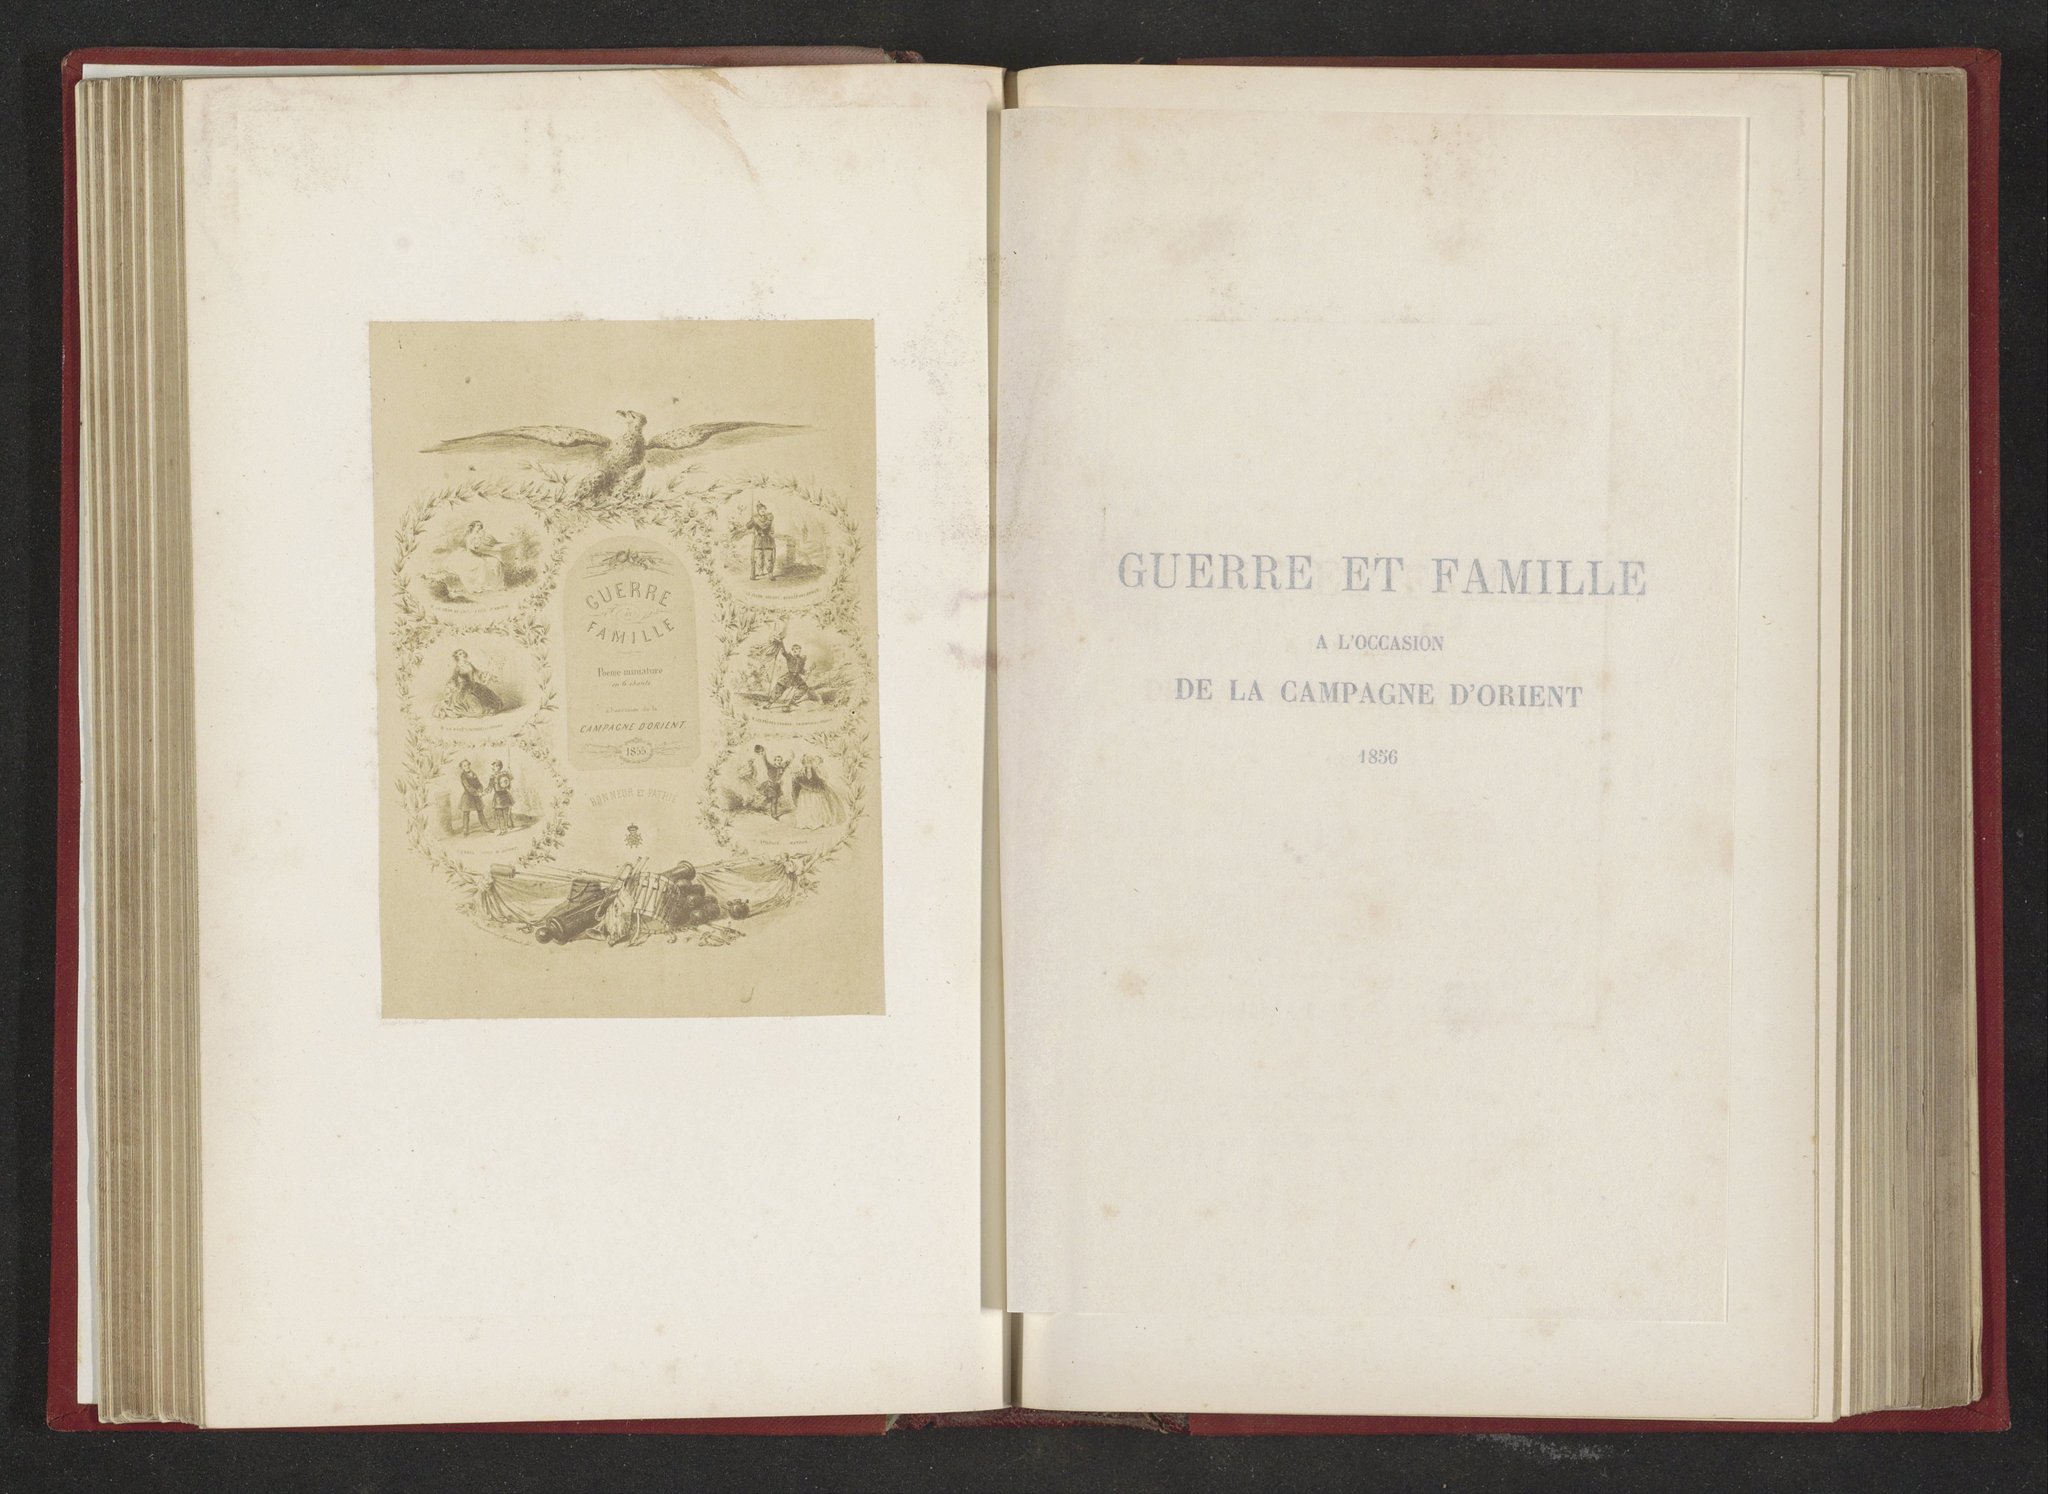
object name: page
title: Zes scenes uit het leven van een soldaat en een vogel rond de tekst: Guerre et famille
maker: collin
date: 1858-1868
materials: photographic support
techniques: albumen print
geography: paris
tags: the soldier; the soldier's life